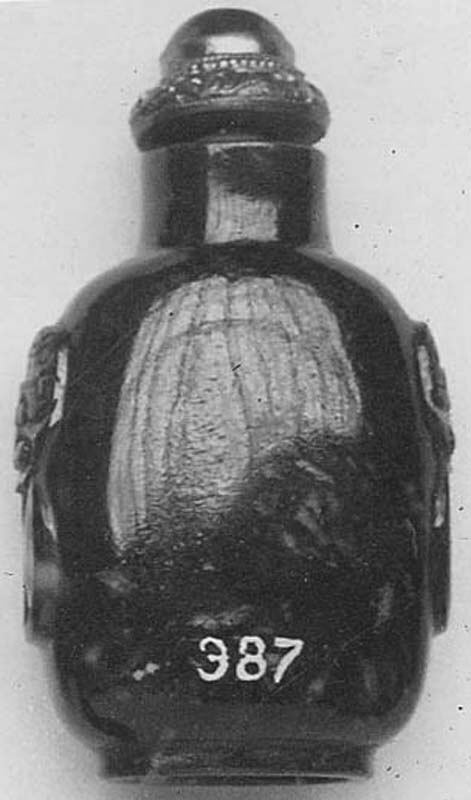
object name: snuff bottle with stopper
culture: chinese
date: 1701-1900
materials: stone